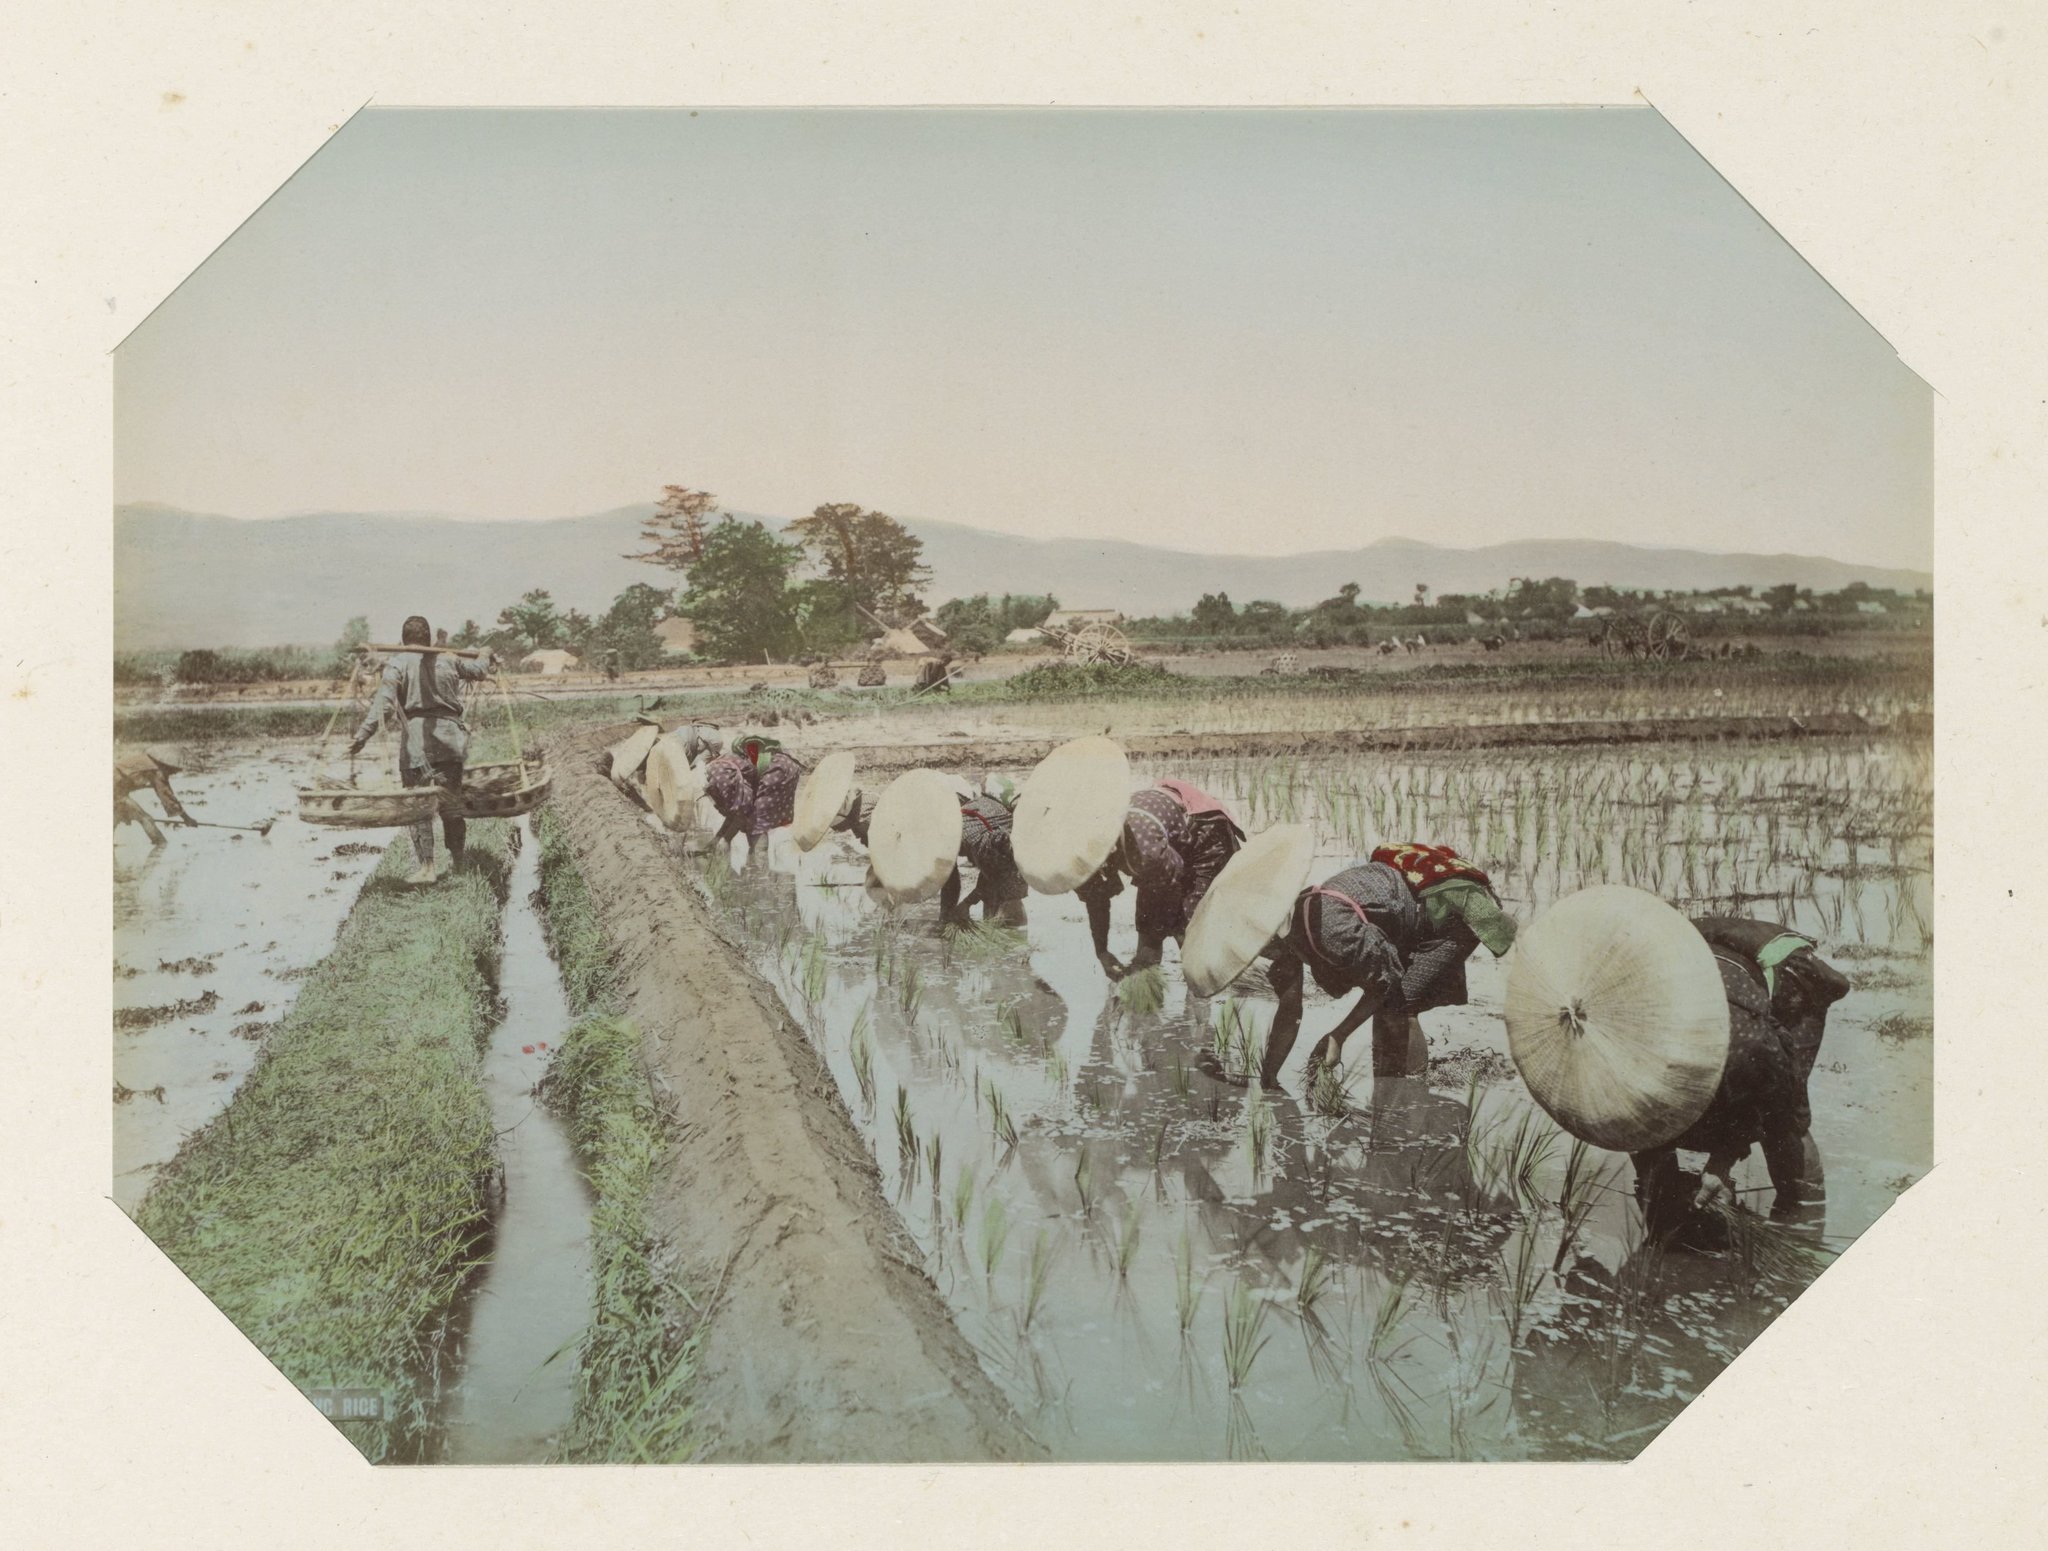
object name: photograph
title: Rijstplantende boeren in Japan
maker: Anonymous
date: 1870-1900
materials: paint, photographic support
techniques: albumen print, hand coloring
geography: japan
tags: field filled with a crop, farmers, cereal, grain, corn (grass with grains, grown for food, e.g.: wheat, rice, rye, oats, maize, buckwheat, millet)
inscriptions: number: ‘Q 4’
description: Onderdeel van Fotoalbum met opnames van bezienswaardigheden in Japan en studioportretten.